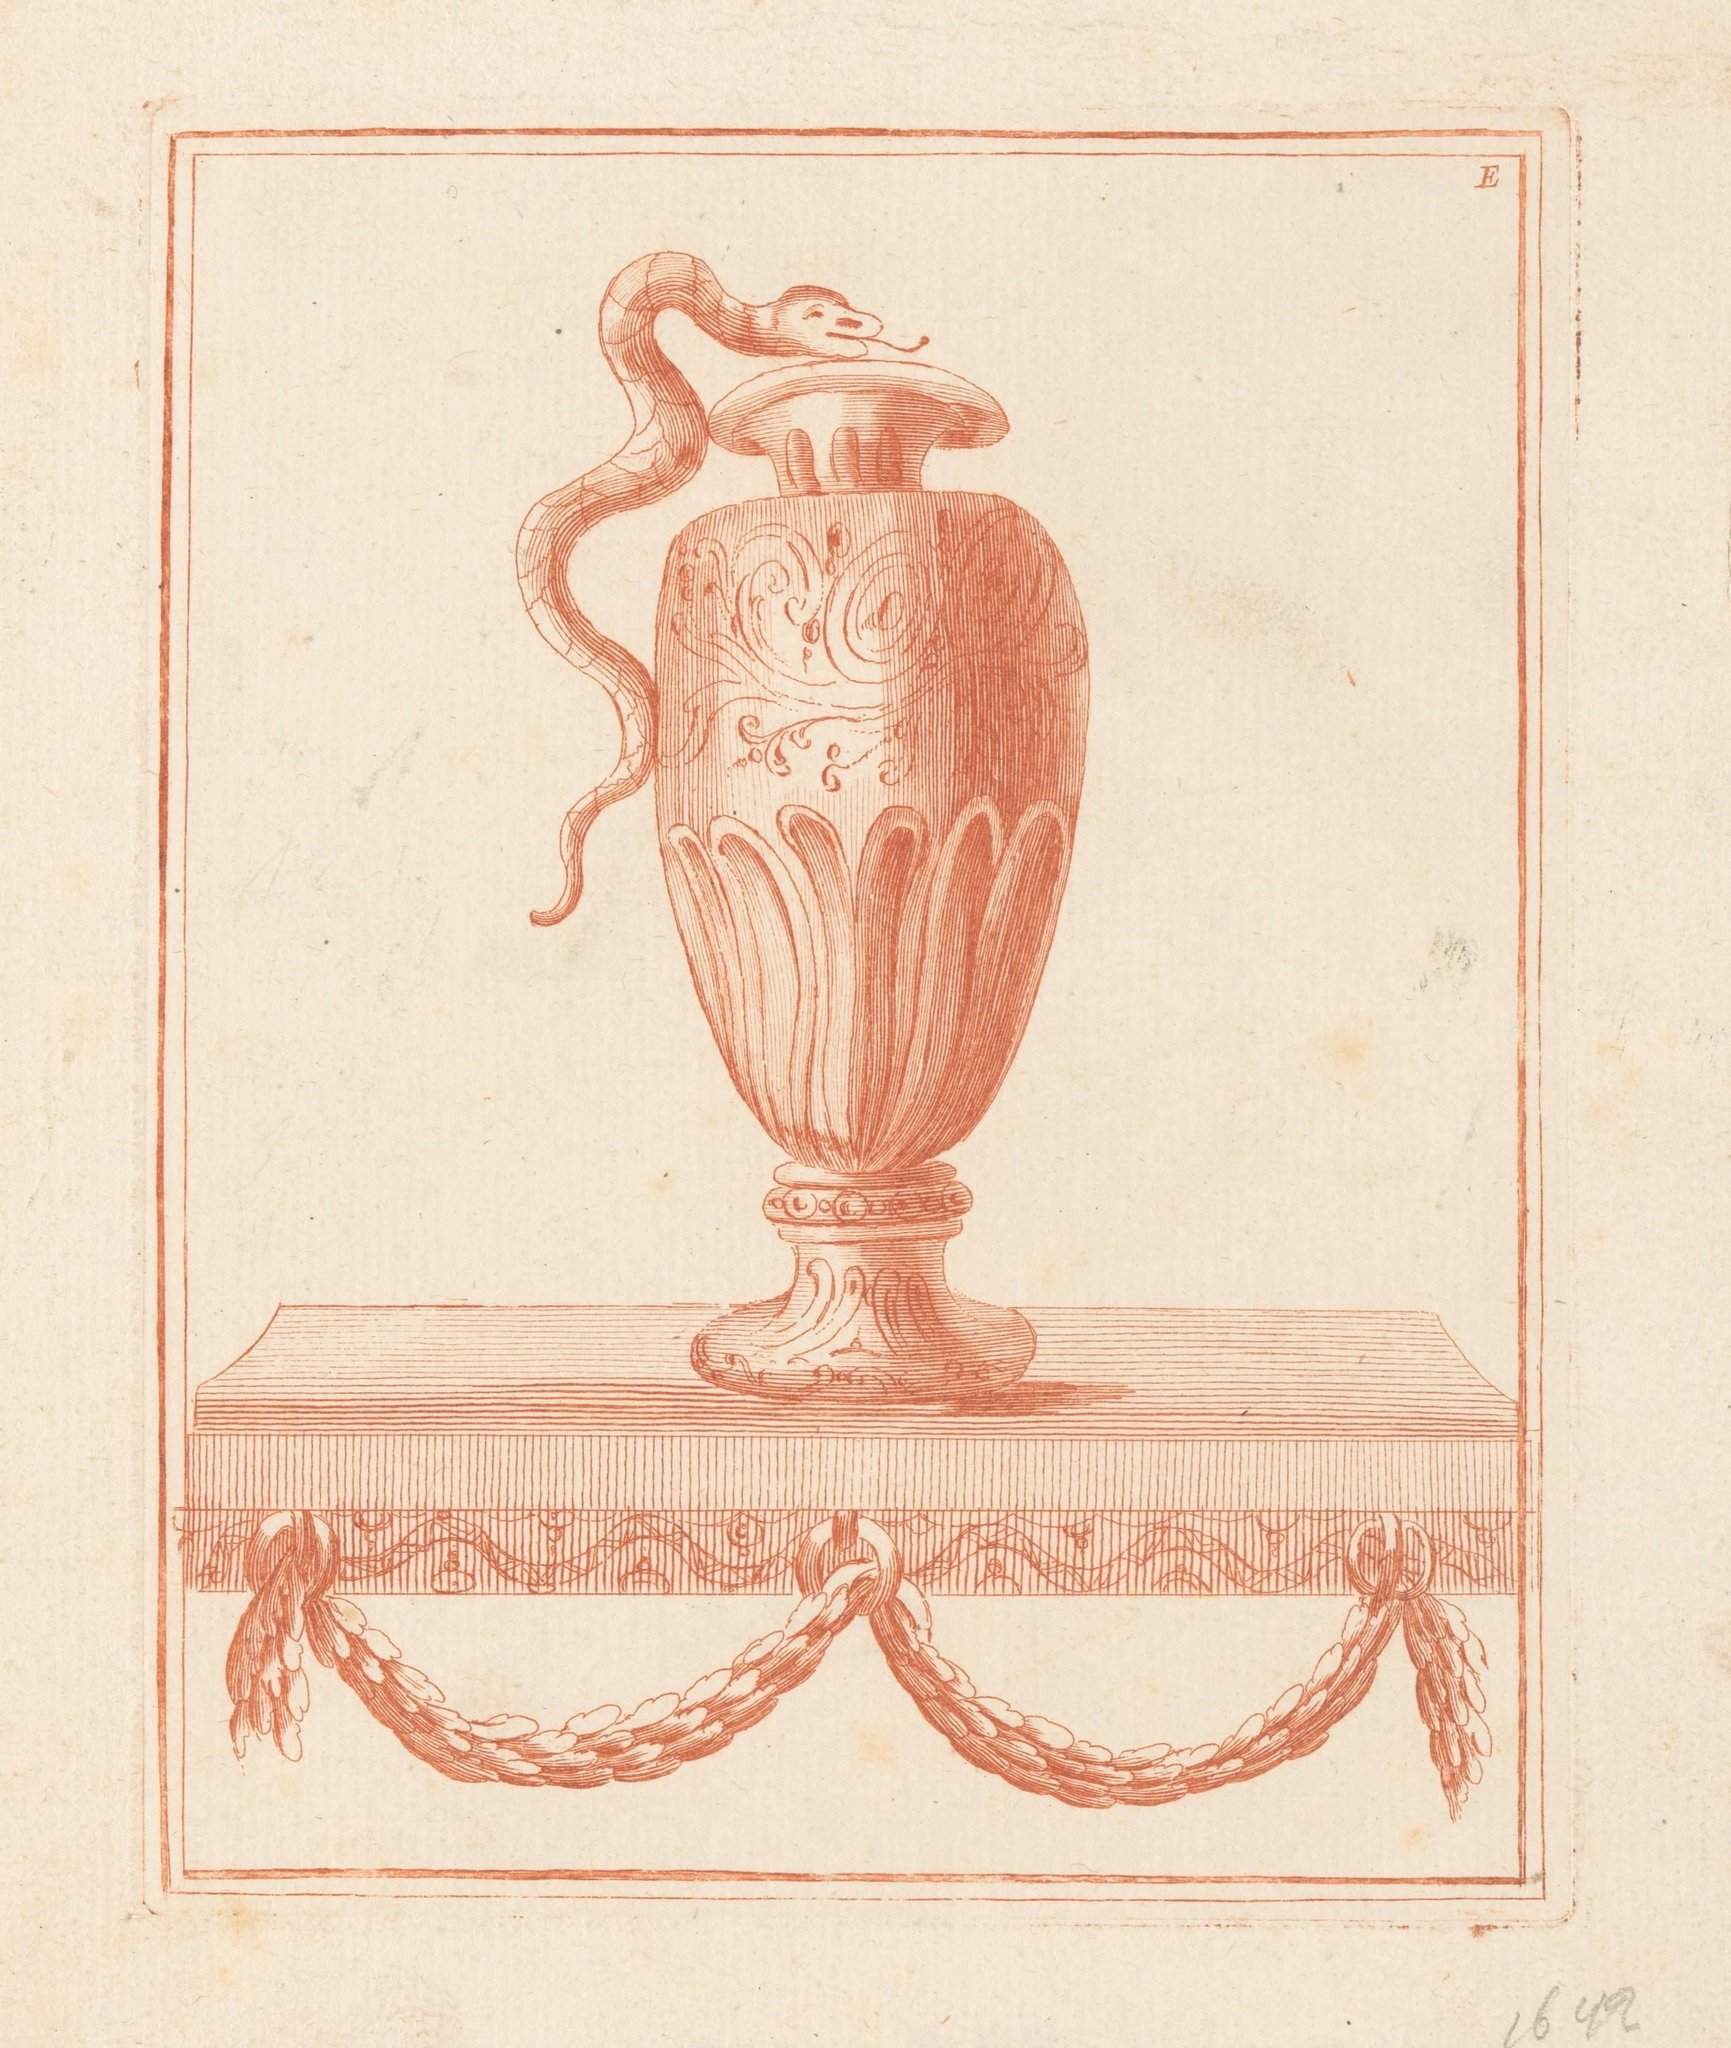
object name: print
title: Vaas met slang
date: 1770-1780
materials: paper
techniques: etching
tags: snakes, vase ~ ornament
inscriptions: collector's mark: Lugt 2228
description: Een geornamenteerde vaas met een slang. Daaronder een guirlande. Rechts boven E genummerd.